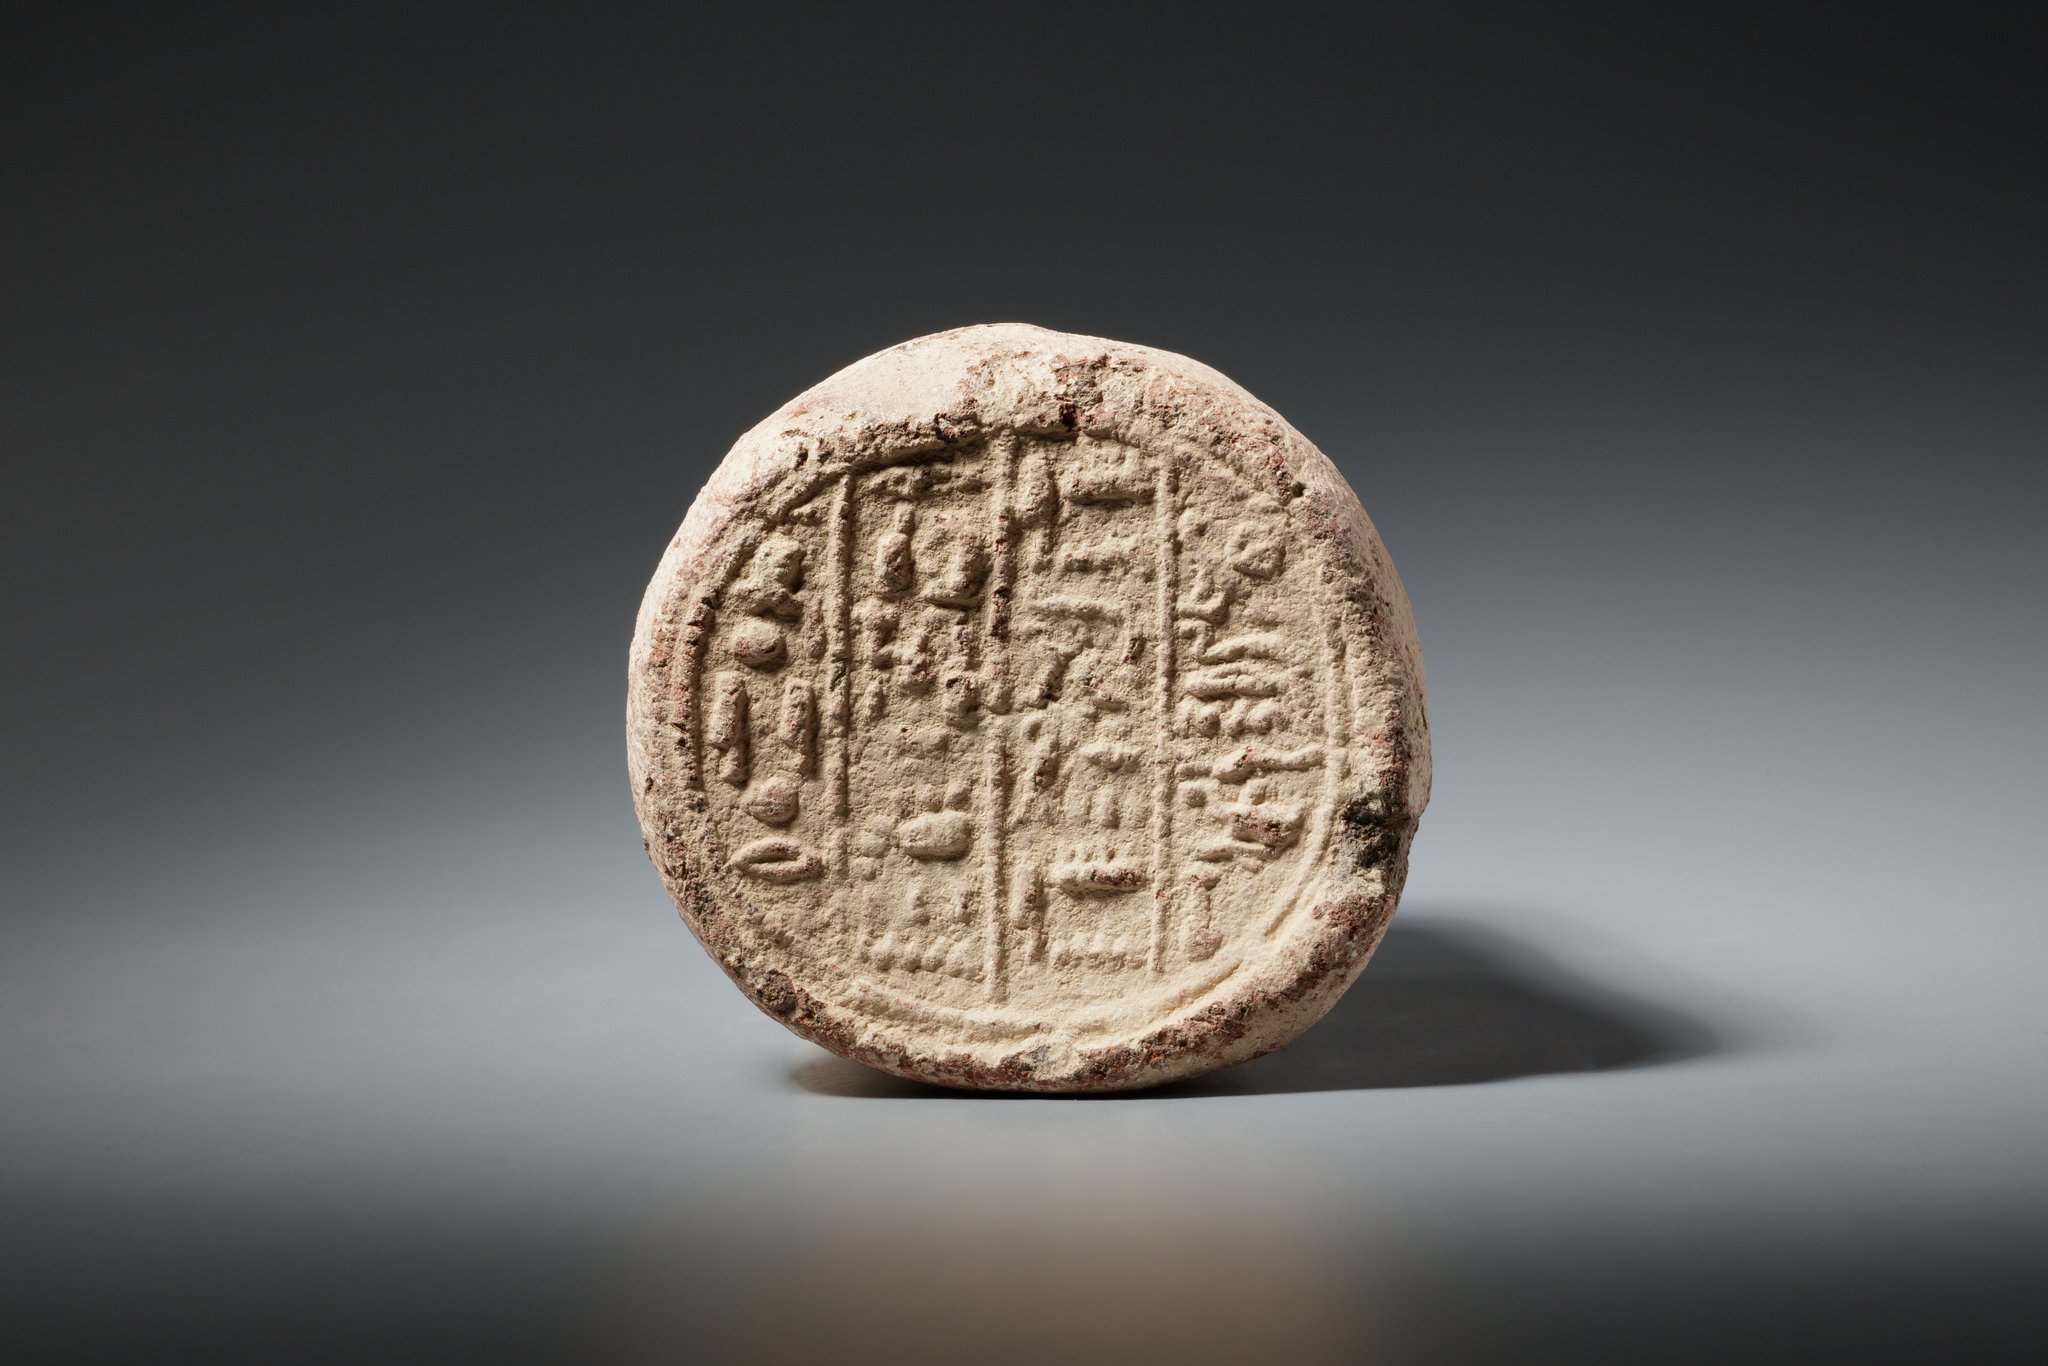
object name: cone, davy 73, amenemopet, tjanefer, scribe, grain, amun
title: Funerary Cone of the Scribe Amenemopet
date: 1400-1352 BCE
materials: pottery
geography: egypt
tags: hieroglyphs